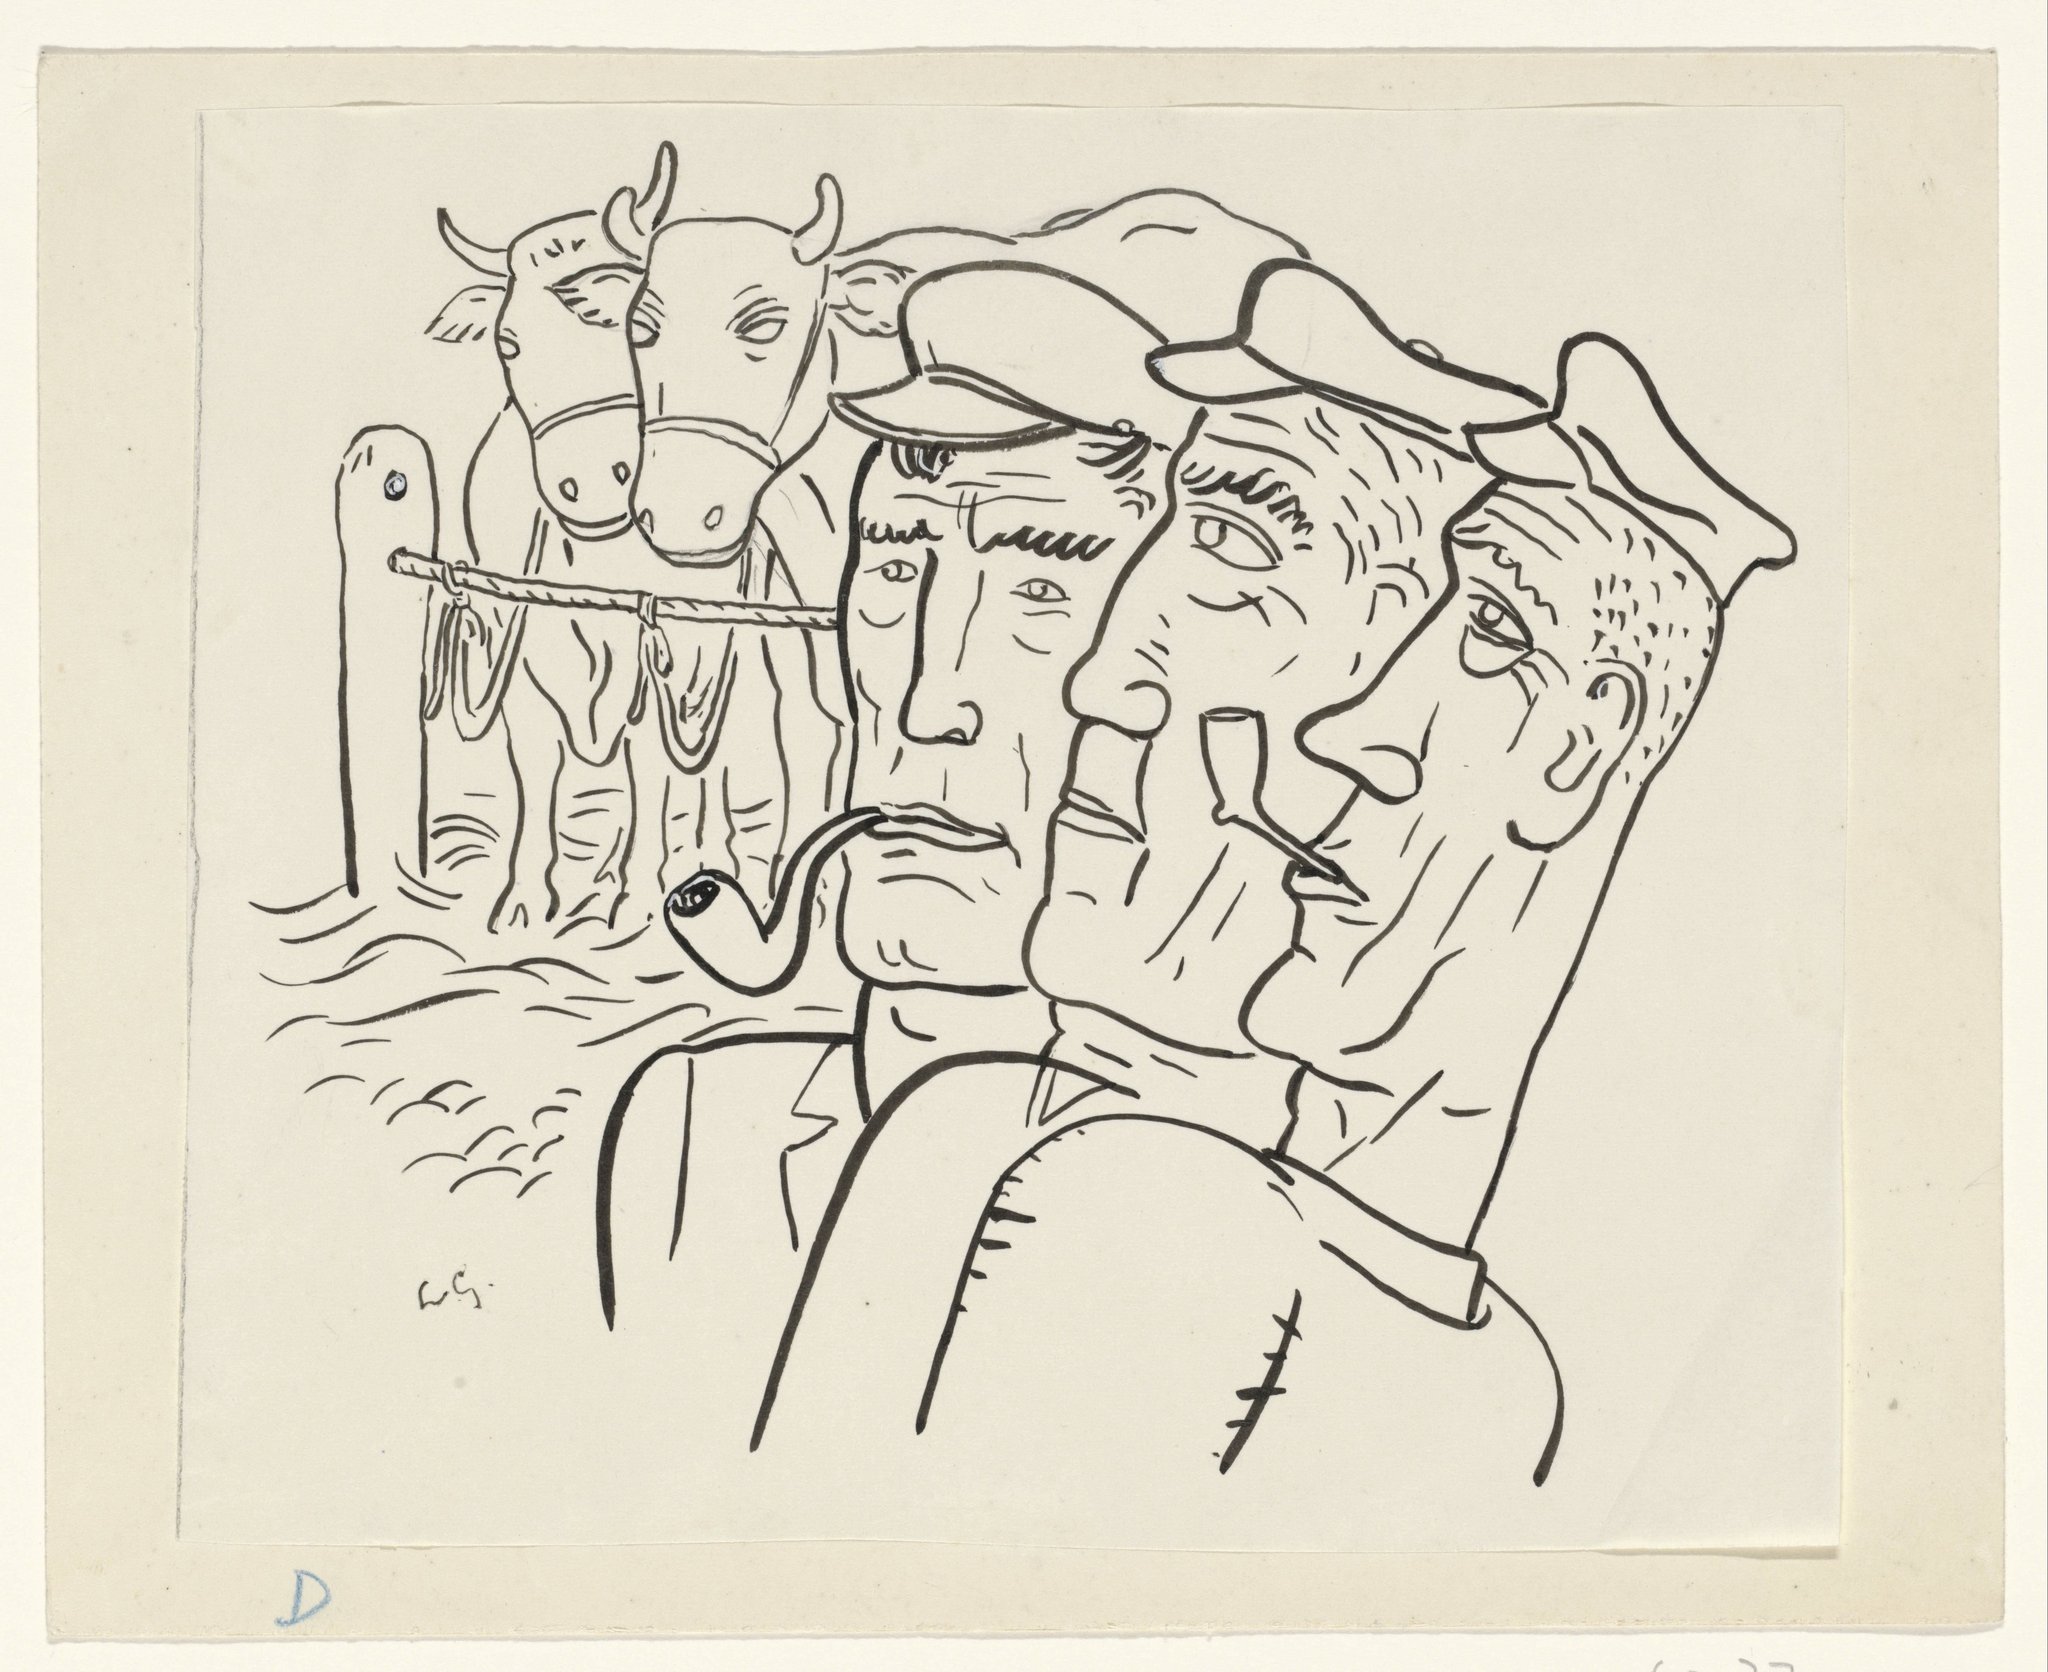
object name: design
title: Drie boeren en twee koeien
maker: leo gestel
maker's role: draughtsman, print maker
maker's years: 1881-1941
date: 1891-1941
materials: paint, ink, paper, pencil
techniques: pen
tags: urban housing, cow, pipe ~ tobacco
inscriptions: collector's mark: Lugt 2228